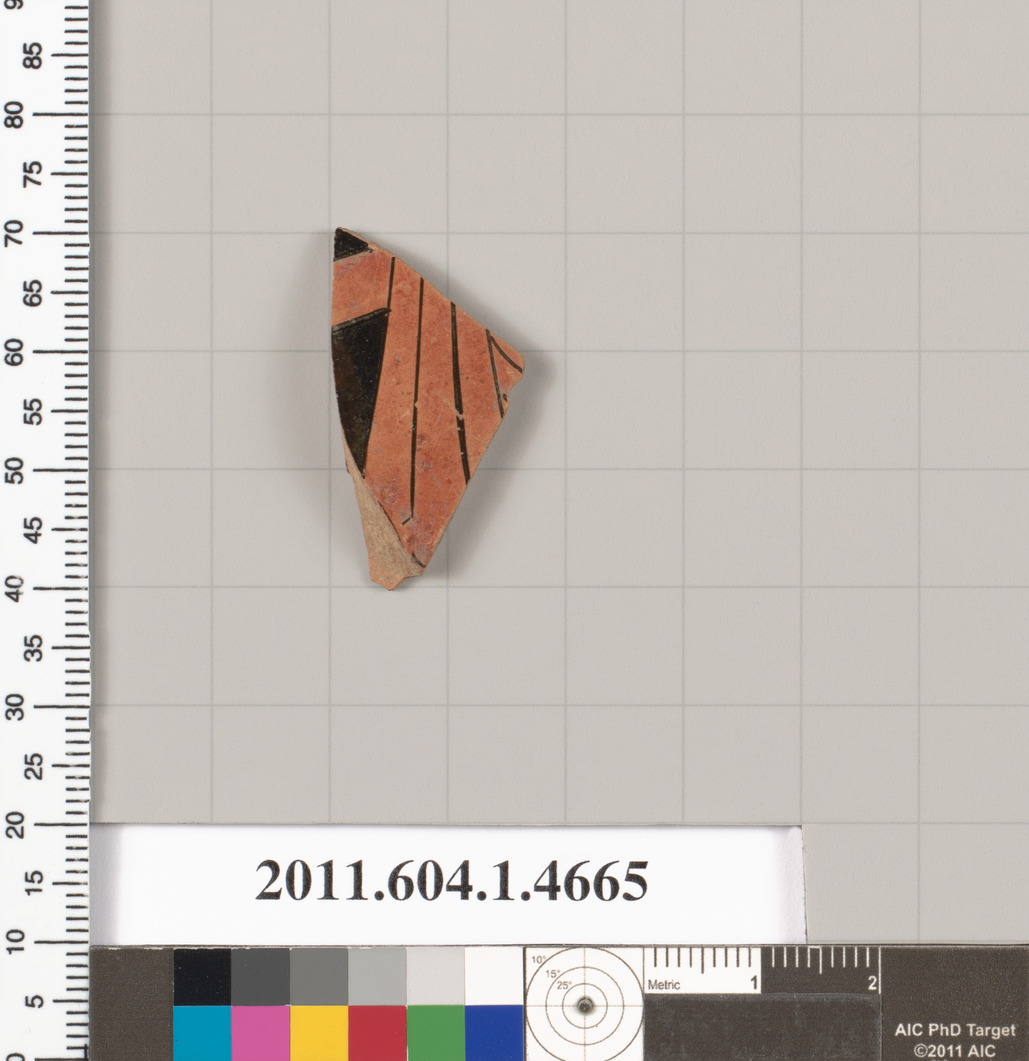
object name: kylix fragment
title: Terracotta fragment of a kylix (drinking cup)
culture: greek, attic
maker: painter of the louvre komoi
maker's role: artist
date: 475-451 BCE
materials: terracotta